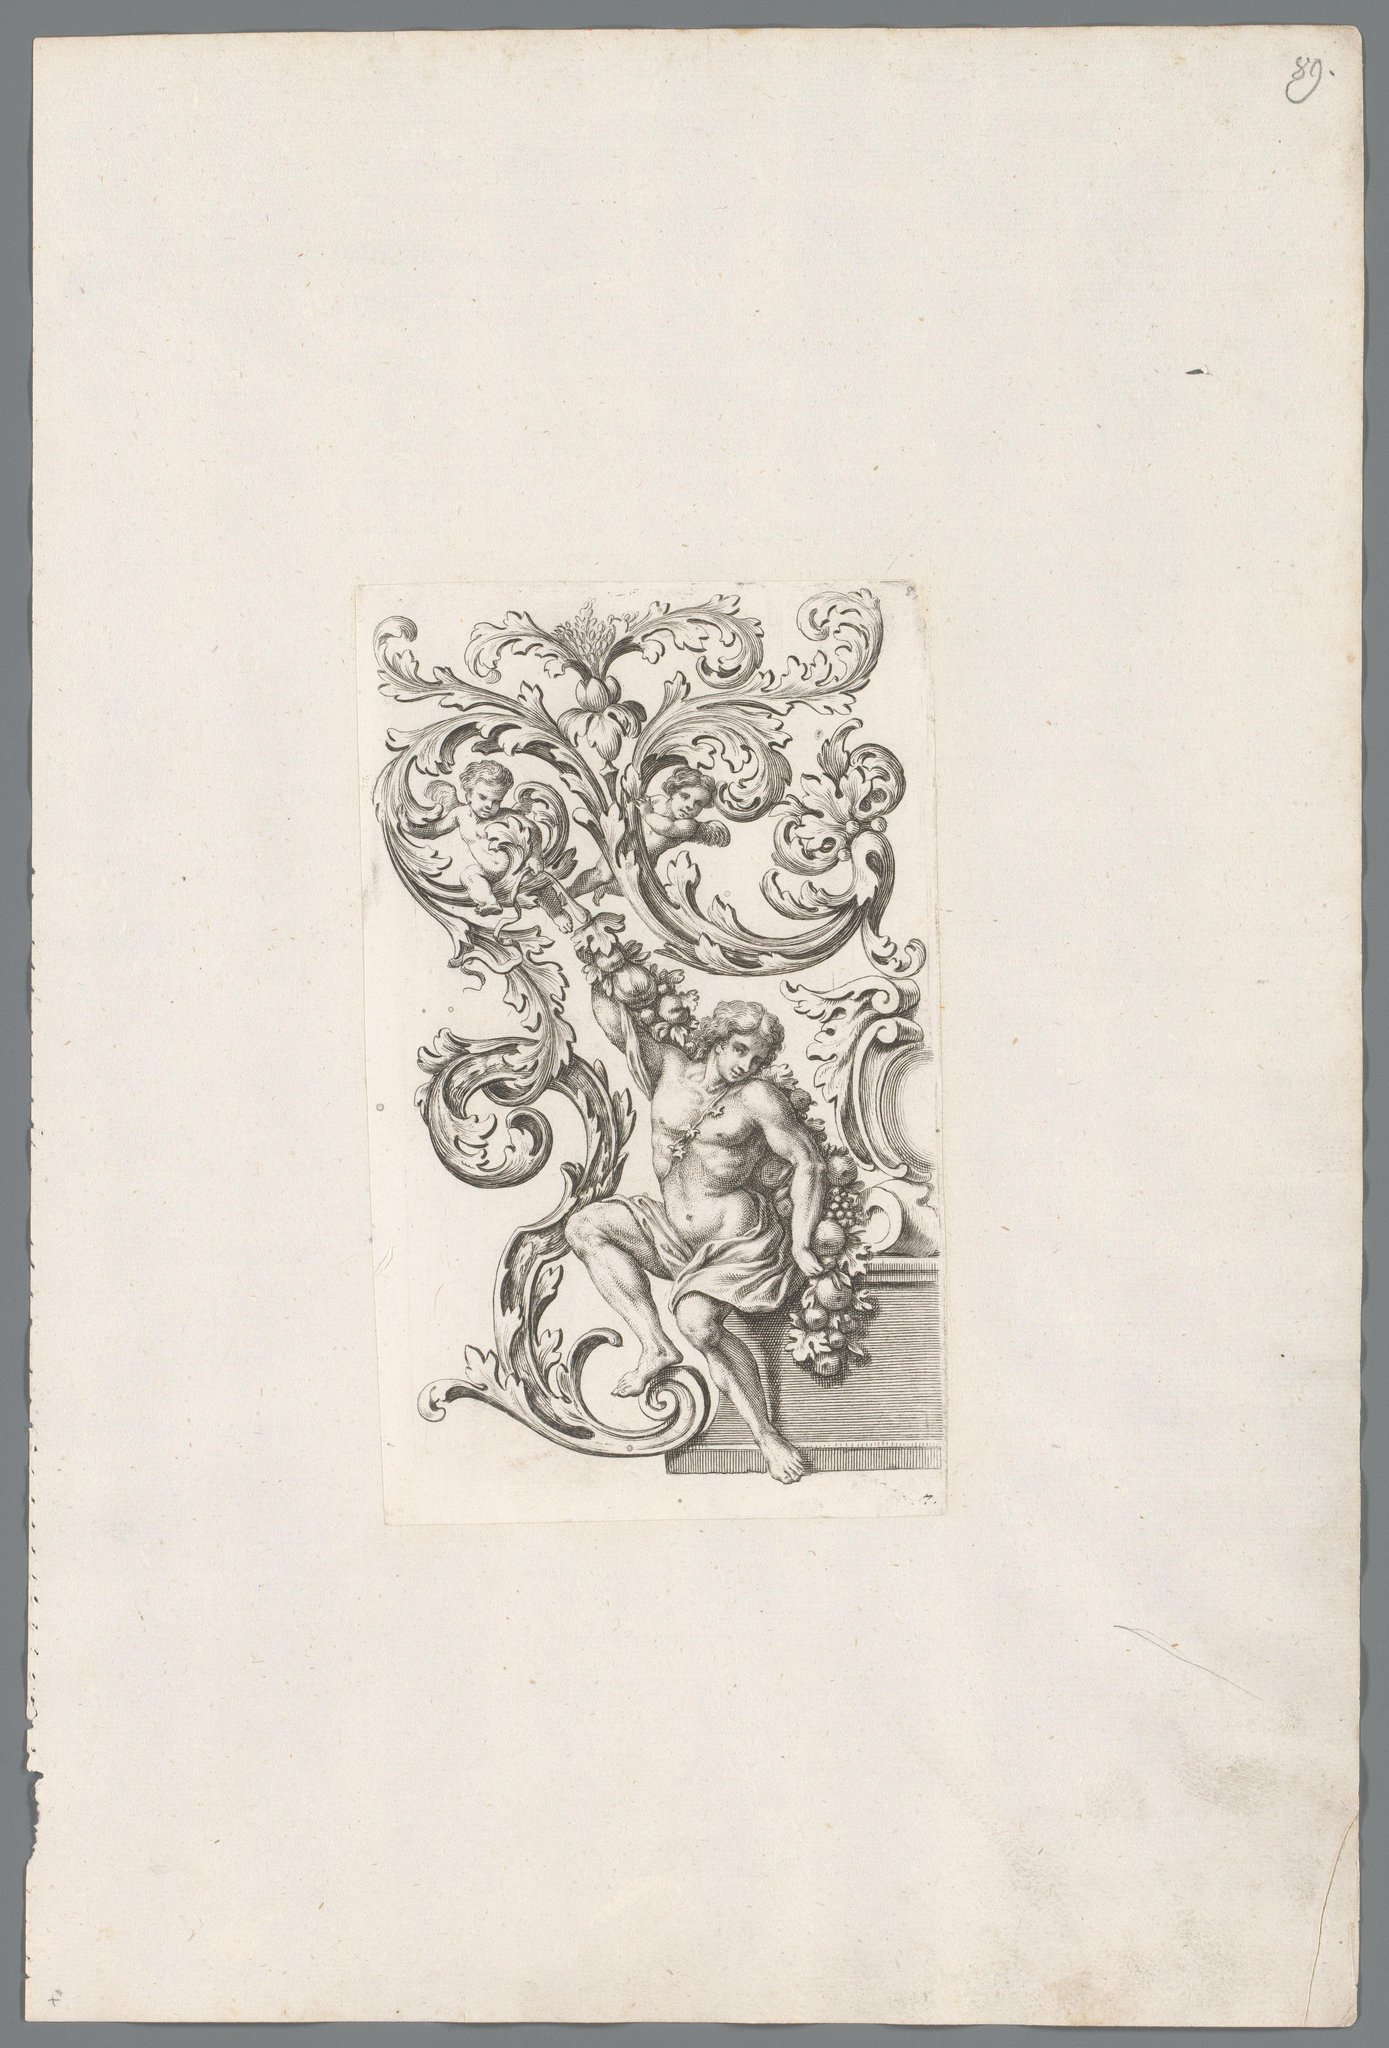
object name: ornament print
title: Man met festoen van fruit bij acanthusmotief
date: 1679-1700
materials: paper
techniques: etching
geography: augsburg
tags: acanthus ~ ornament, ornament ~ festoon, garland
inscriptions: collector's mark: Lugt 2228, collector's mark: Lugt 2760